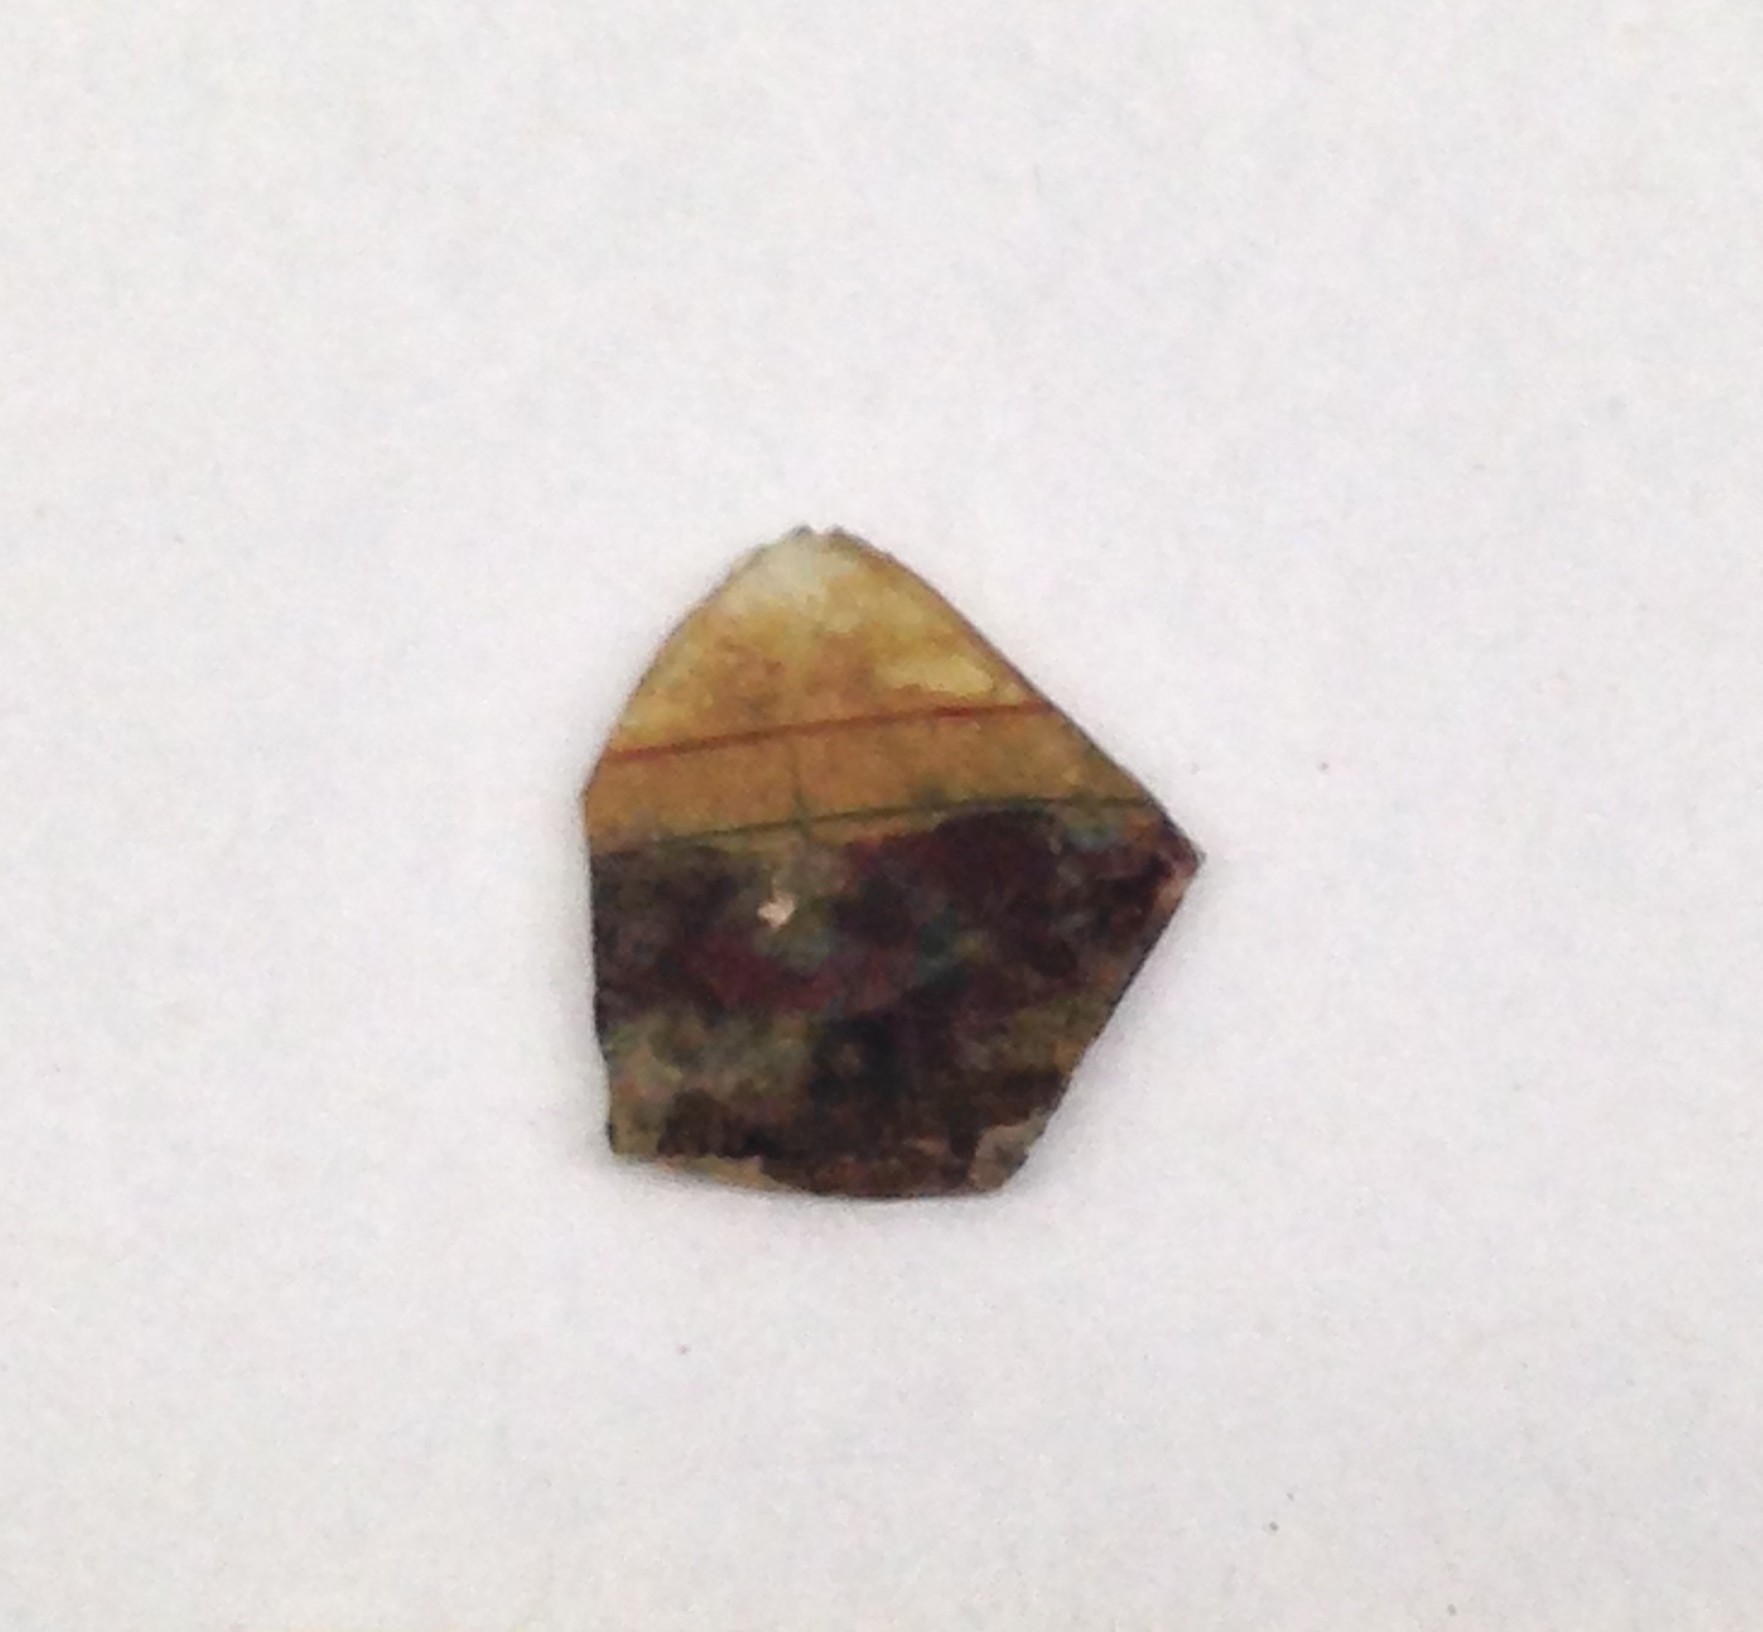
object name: fragment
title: Glass Fragment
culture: crusader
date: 1201-1300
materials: glass